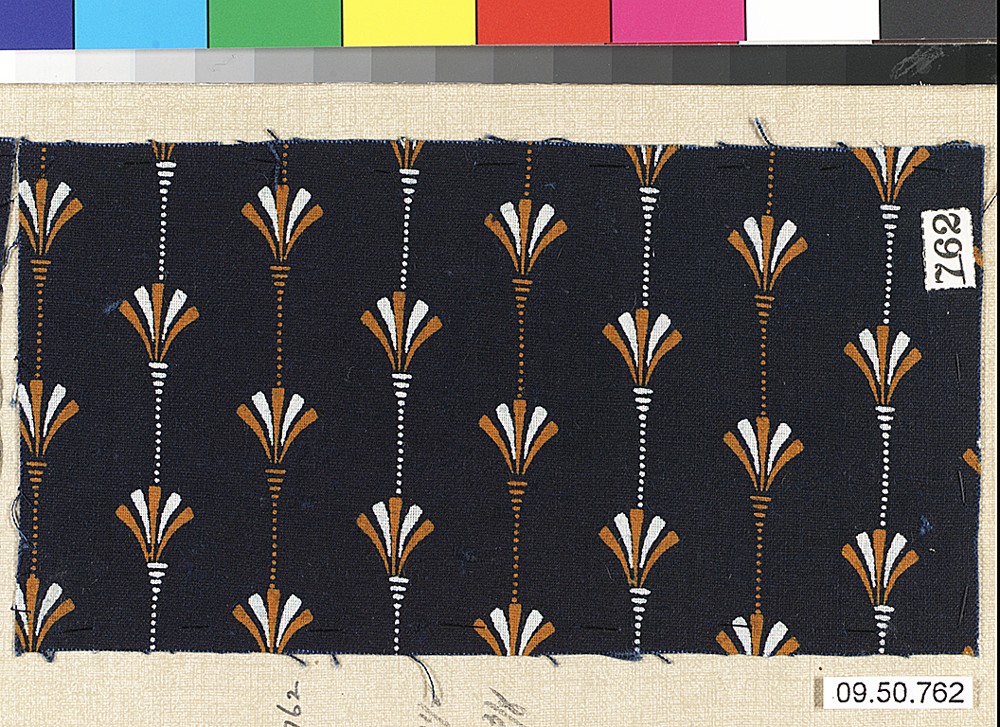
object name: piece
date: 1801-1900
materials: cotton